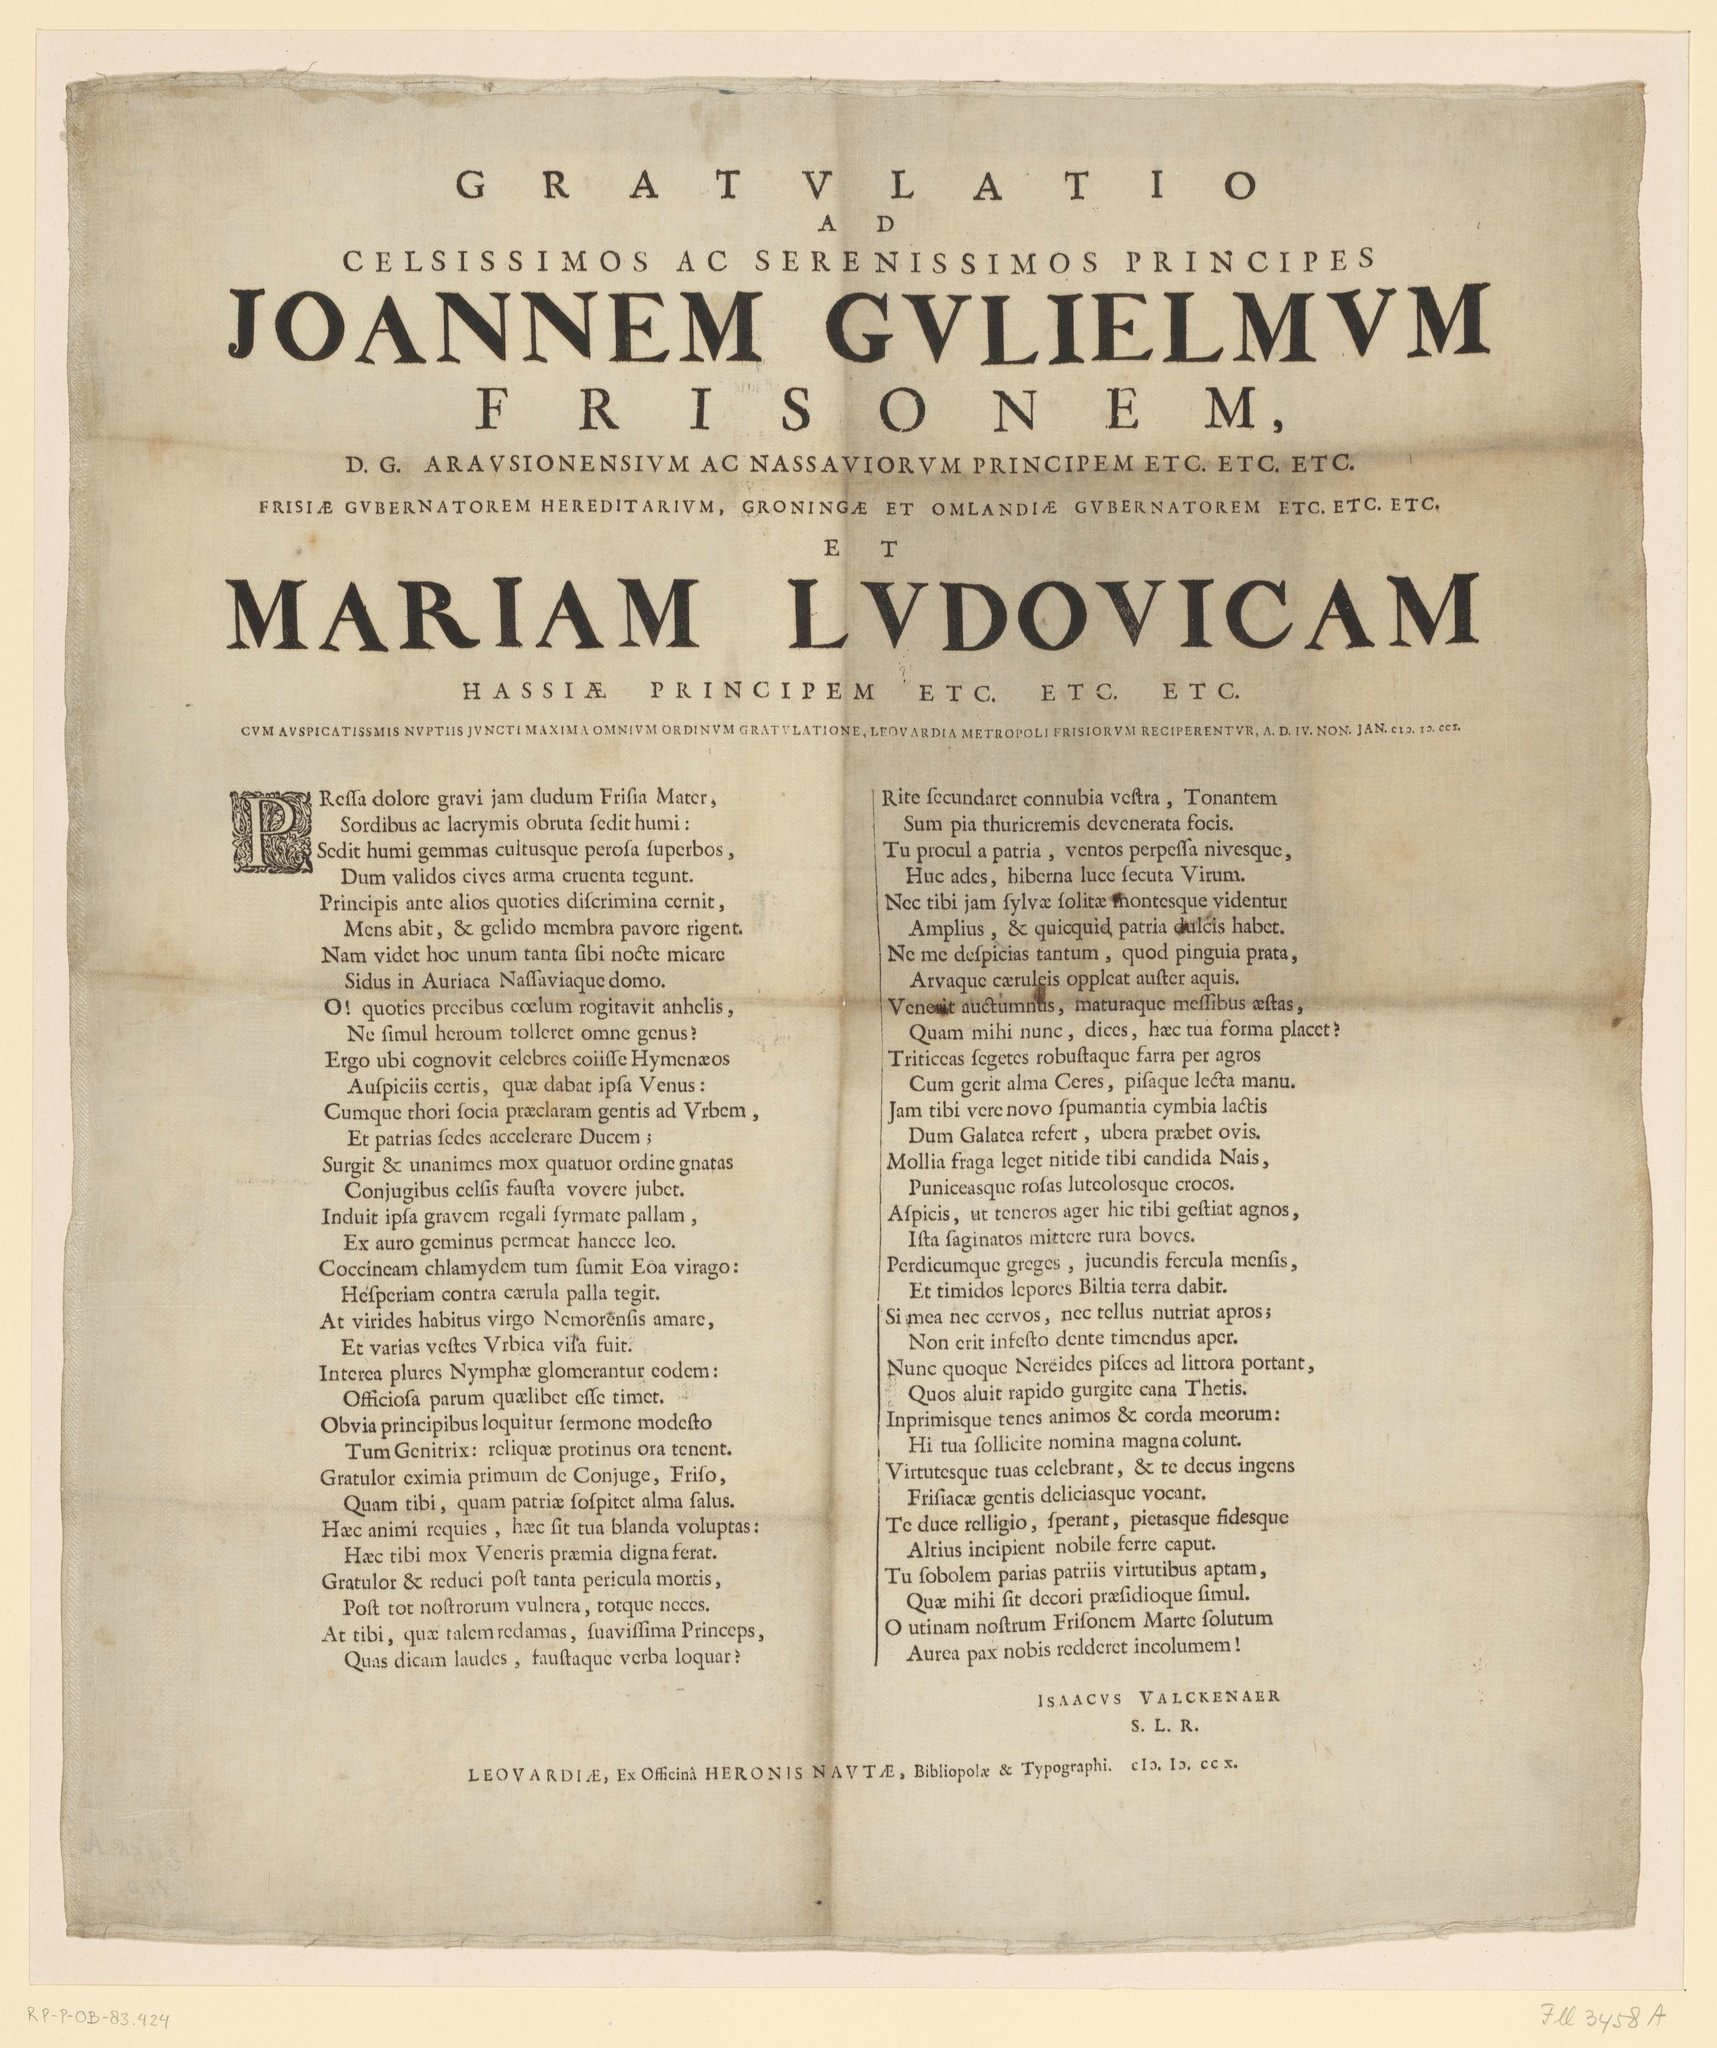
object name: text sheet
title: Gelukswens aan Johan Willem Friso en Maria Louise bij hun intocht te Leeuwarden, 1710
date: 1710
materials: silk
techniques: letterpress printing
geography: leeuwarden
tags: johan willem friso (prins van oranje-nassau)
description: Op zijde gedrukt gelukswens aan prins Johan Willem Friso en prinses Maria Louise bij hun intocht te Leeuwarden op 2 januari 1710. Tekst in het Latijn in twee kolommen.